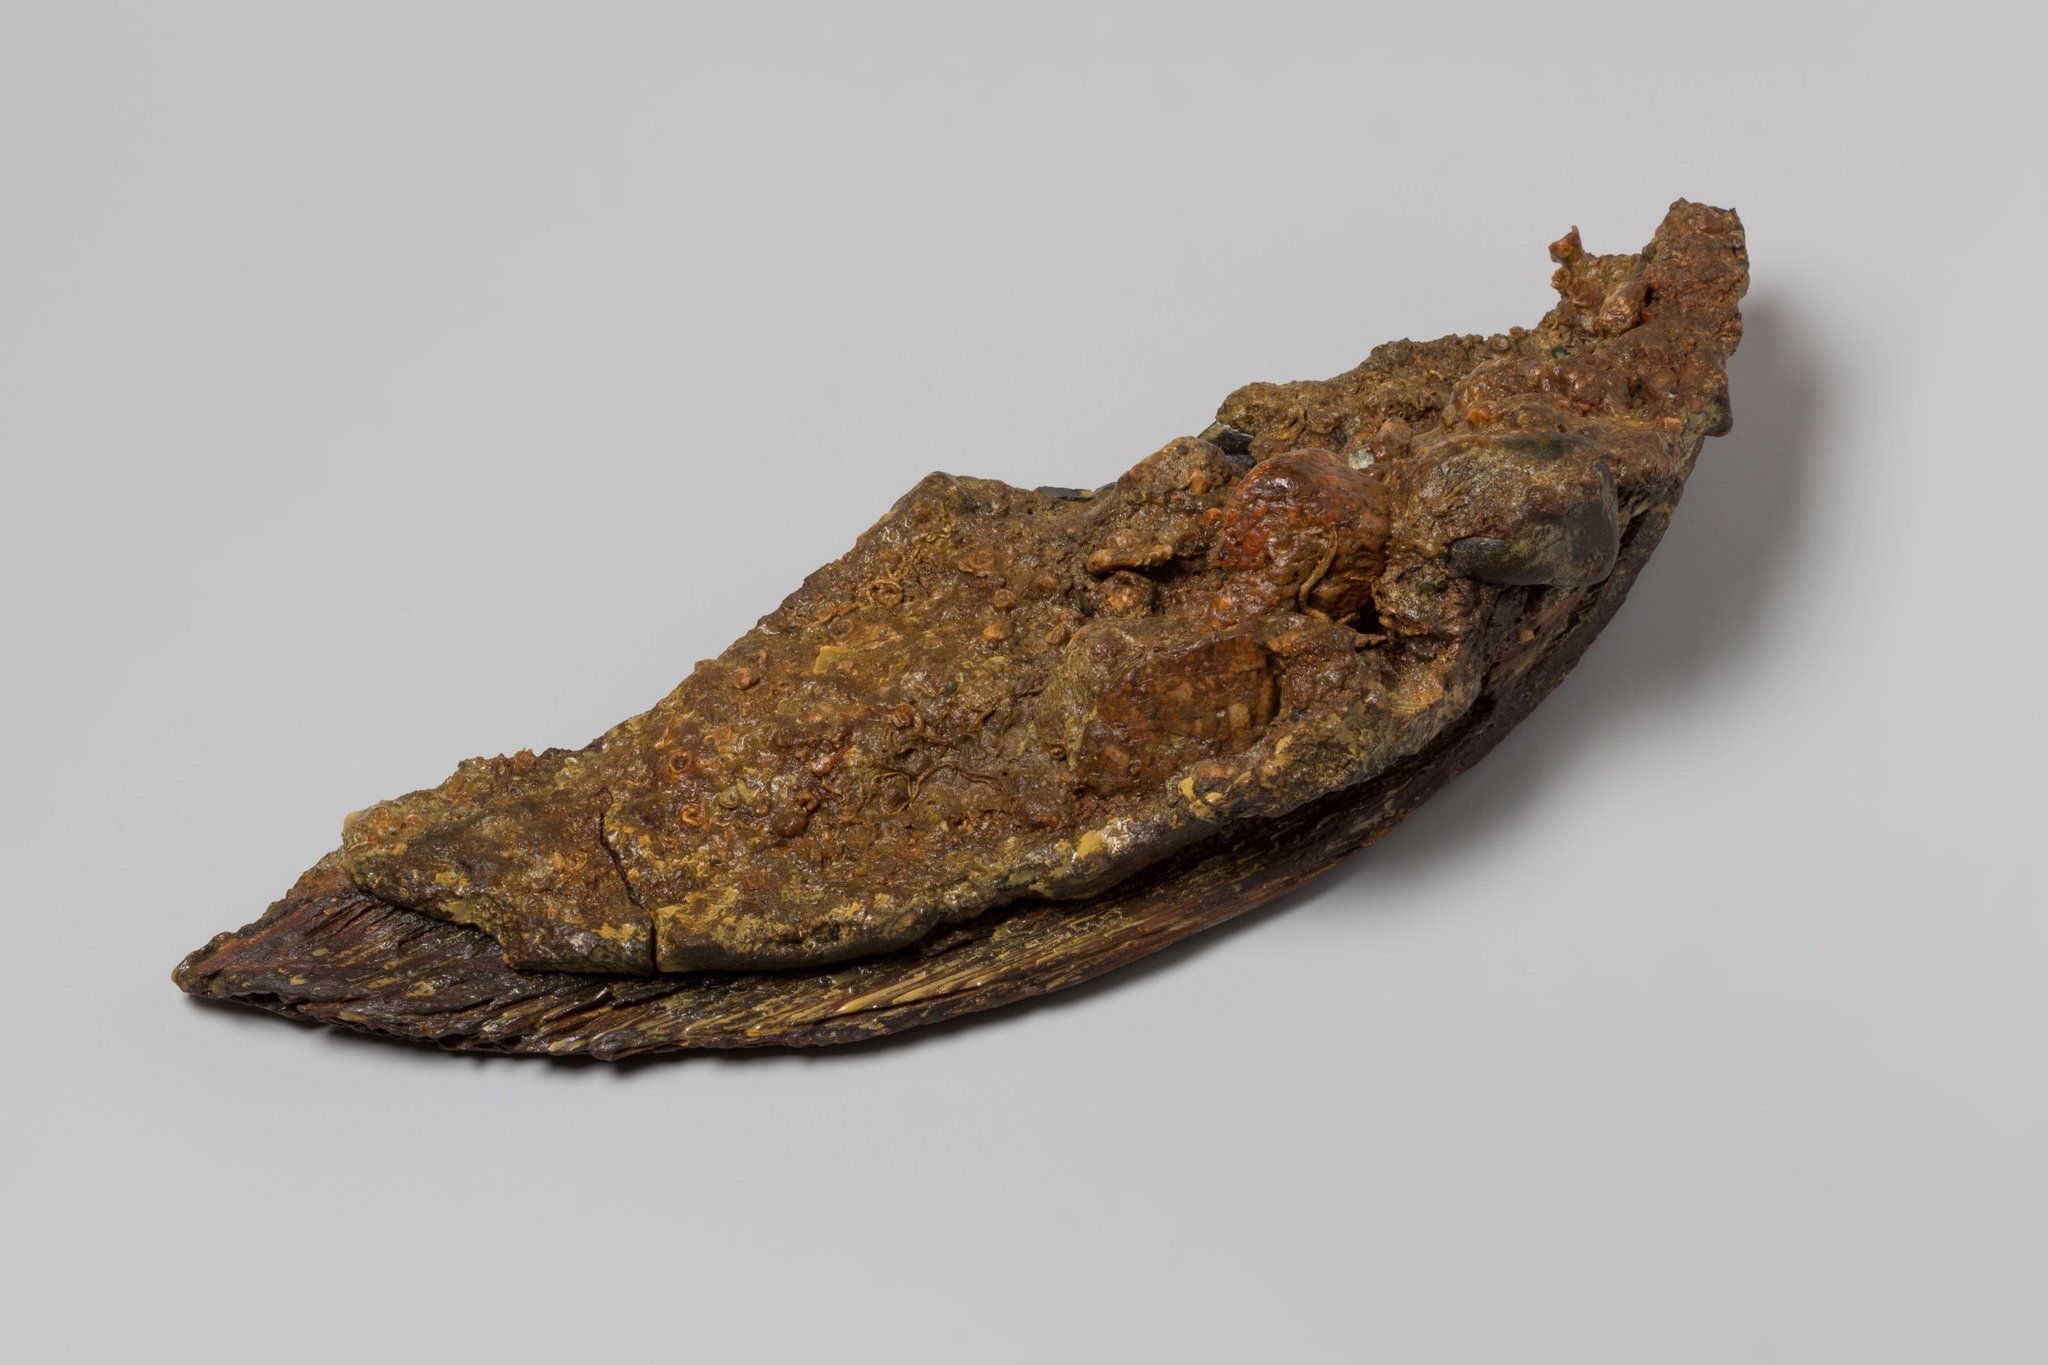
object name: vessel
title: Deksel of bodemfragment van een vat of ton uit het wrak van de in 1735 vergane Oost-Indiëvaarder 't Vliegend Hart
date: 1700-1735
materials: wood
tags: 't vliegend hart (schip), verenigde oostindische compagnie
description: Het fragment van een houten deksel van een vat is oorspronkelijk rond geweest. Nu is ongeveer een derde ervan over. Vermoedelijk eikenhout, bruin, aan een kant concretie, de andere schoon. Barrel.